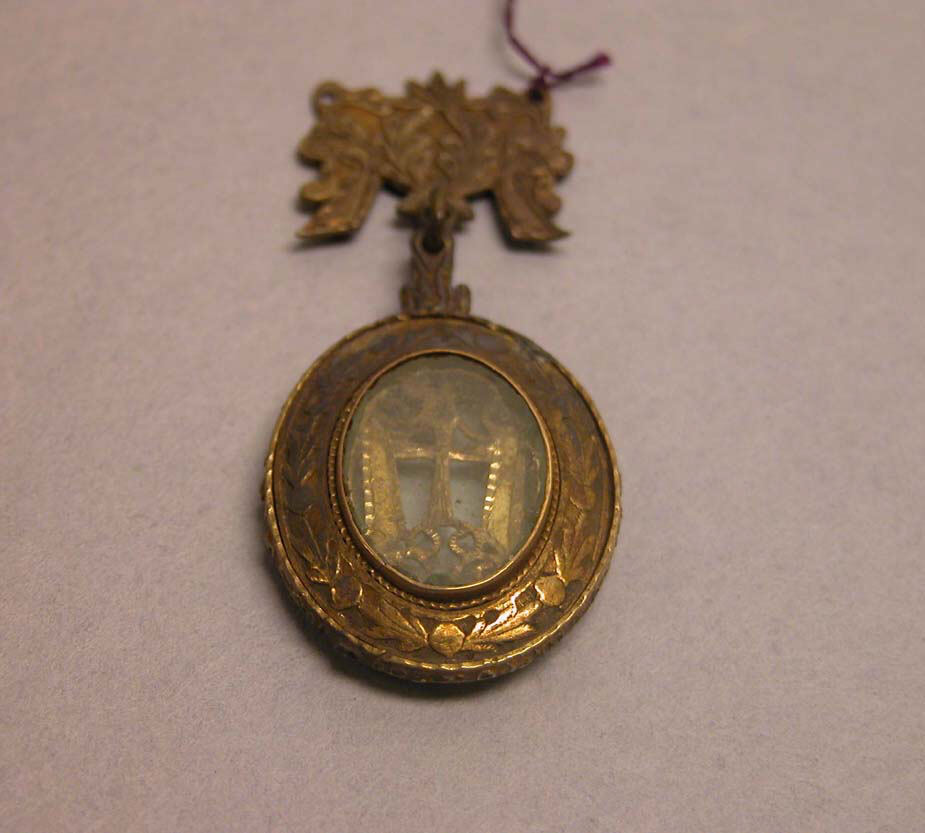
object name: pendant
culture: filipino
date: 1601-1900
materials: gold